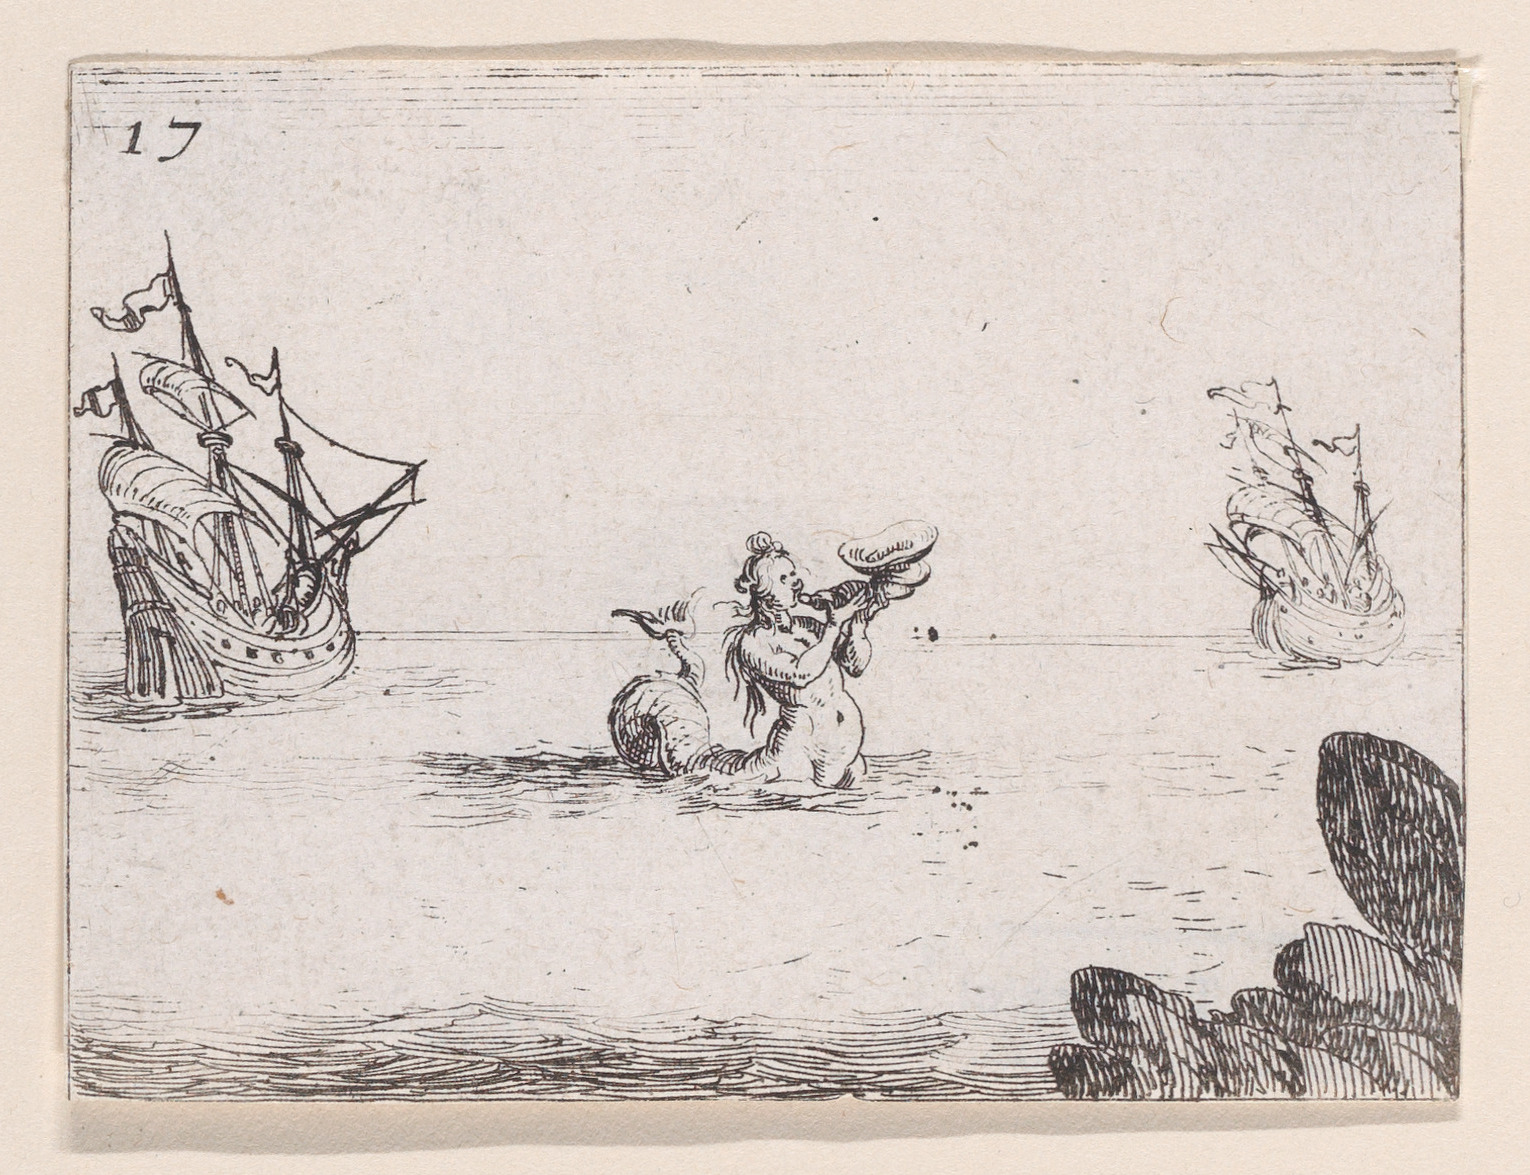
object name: print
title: Une Sirène entre Deux Vaisseaux (A Siren between Two Ships), plate 17 from "Lux Claustri ou La Lumière du Cloitre" (The Light of the Cloisters)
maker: jacques callot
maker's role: artist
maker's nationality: french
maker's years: 1592-1635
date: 1621-1635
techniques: etching